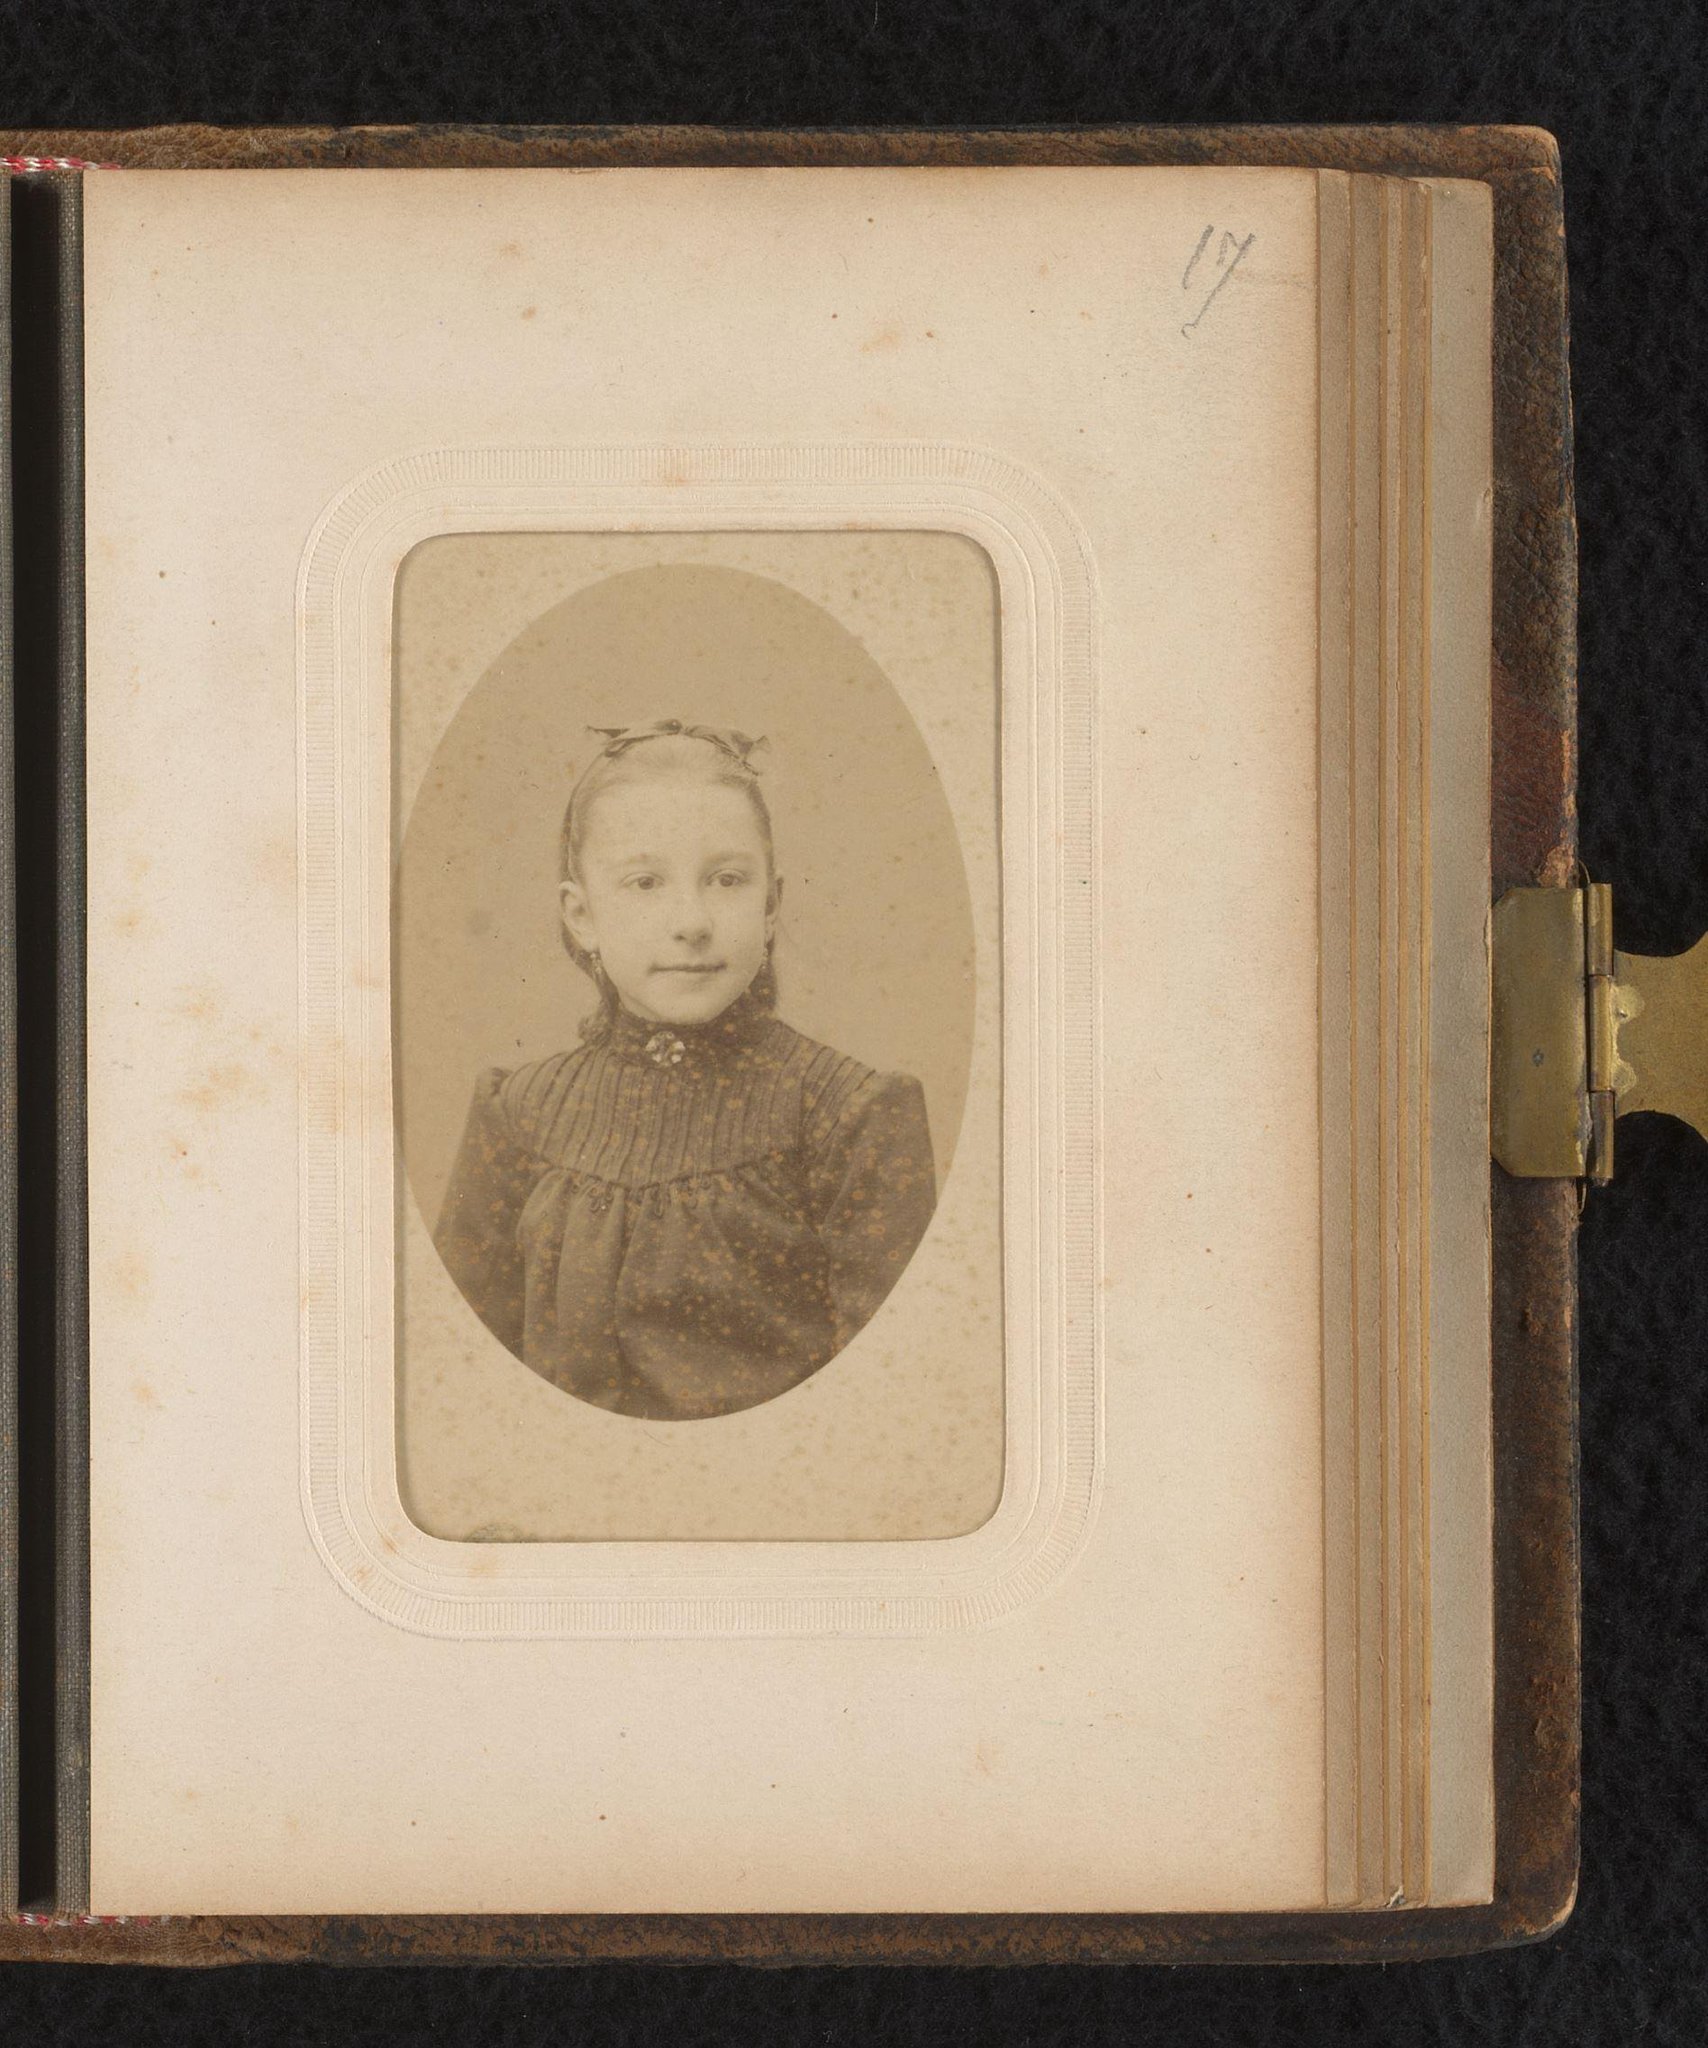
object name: carte de visite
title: Portret van Cornelia Maria Bon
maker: cornelis johannes lodewicus vermeulen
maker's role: fotograaf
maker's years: 1861-1936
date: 1888-1892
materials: cardboard, paper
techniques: albumen print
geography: amsterdam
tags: historical persons - bb - woman, girl (child between toddler and youth)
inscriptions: inscription: ‘C.J.L. Vermeulen/ Amsterdam/ Heerenstraat 6’, inscription: ‘Atelier/ Vermeulen/ Speciaal ingericht (...) Heerenstraat 6’, inscription: ‘Cornelia Maria/ Bon’